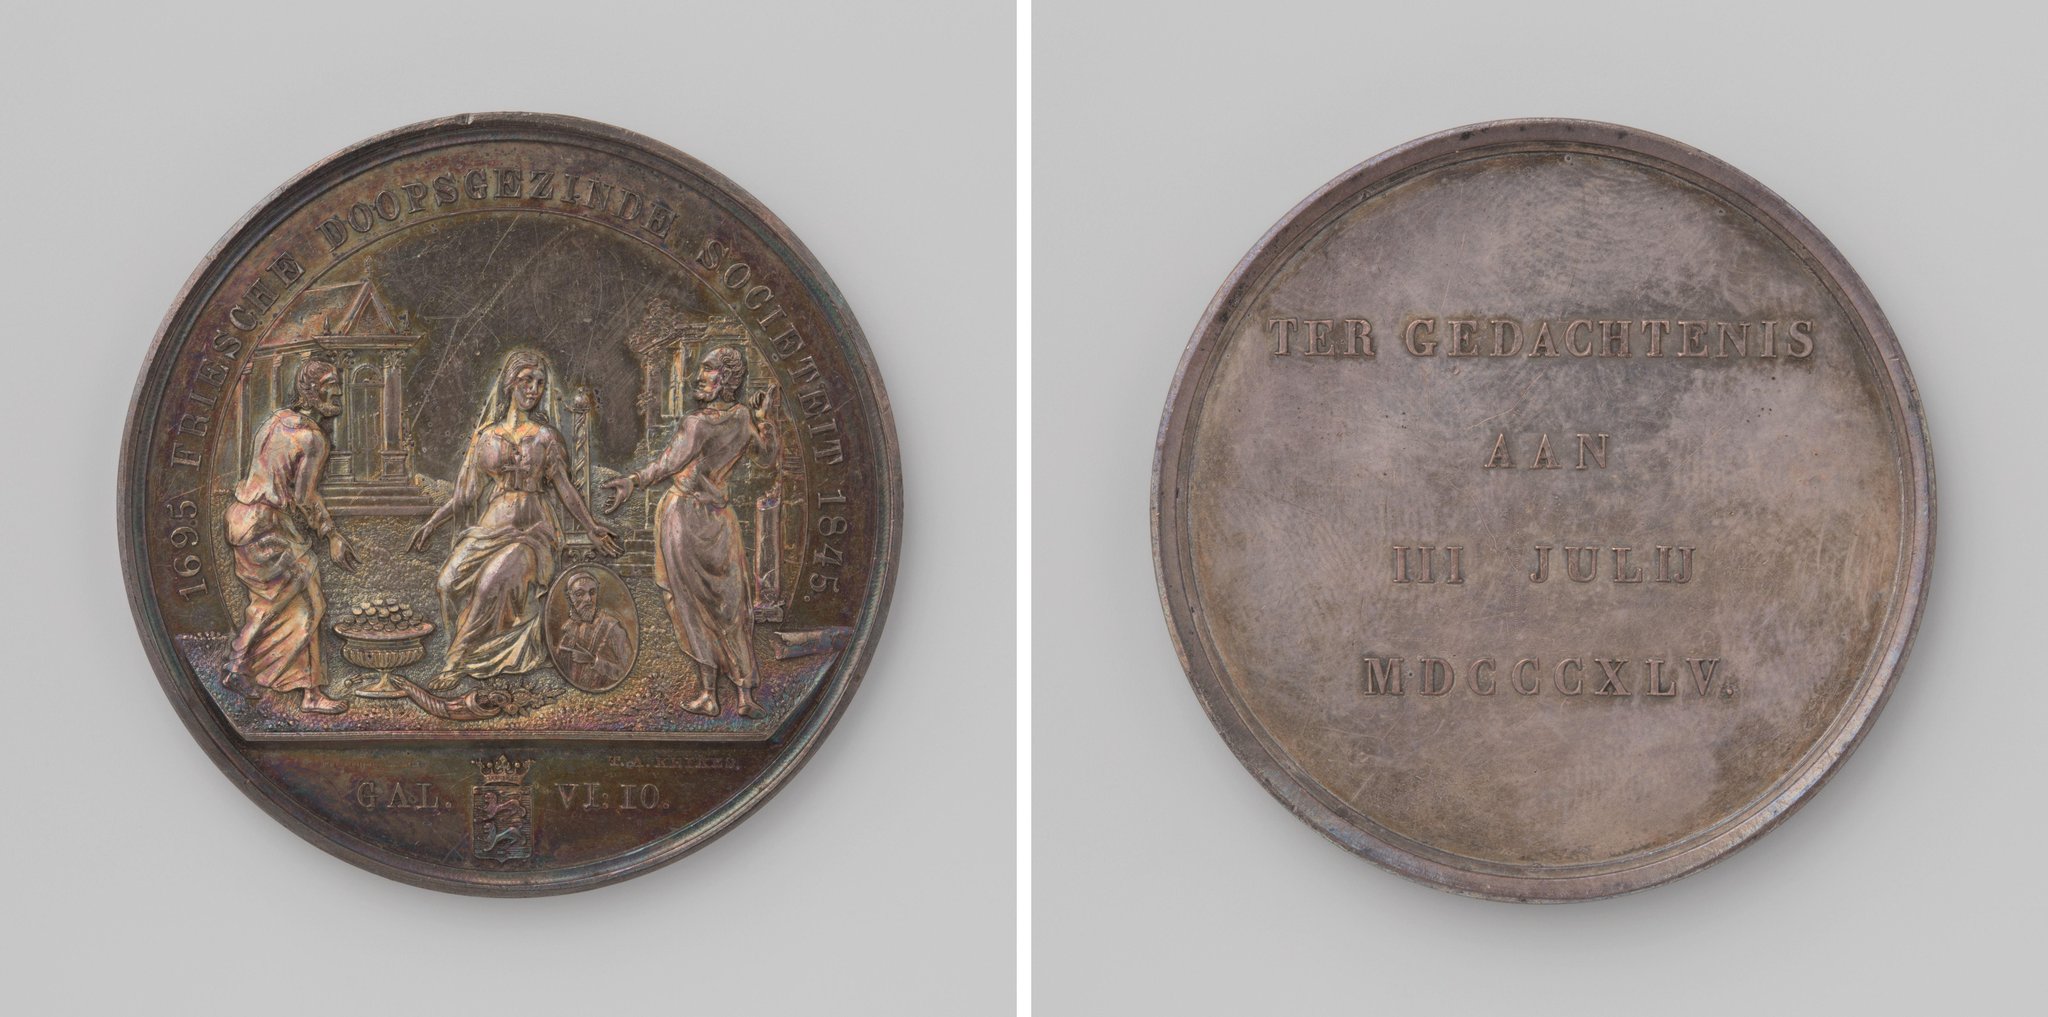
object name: history medal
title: Honderdvijftigjarig bestaan van de Friese Doopsgezinde Societeit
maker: tjeerd keikes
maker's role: medailleur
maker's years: 1804-1886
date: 1845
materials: silver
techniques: striking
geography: leeuwarden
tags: clergyman